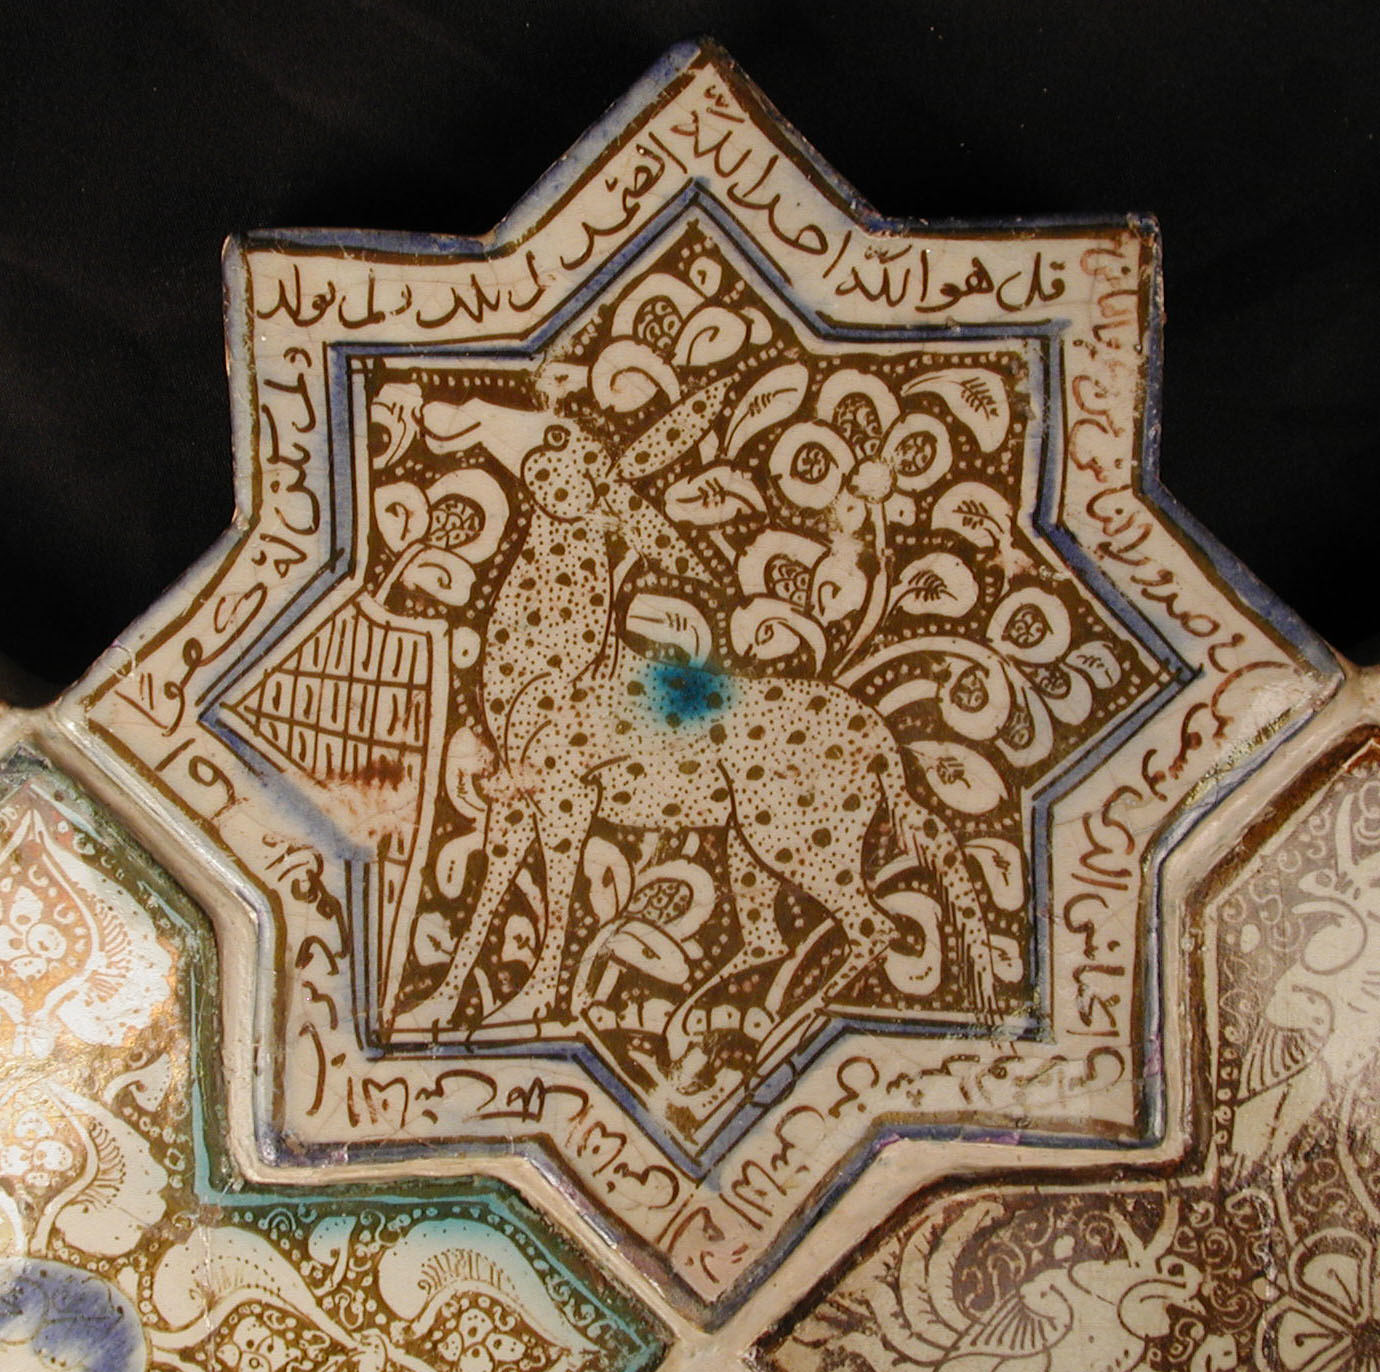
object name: star shaped tile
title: Star-Shaped Tile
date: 1201-1300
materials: glaze, stonepaste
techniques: luster painting, painting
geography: iran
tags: animals